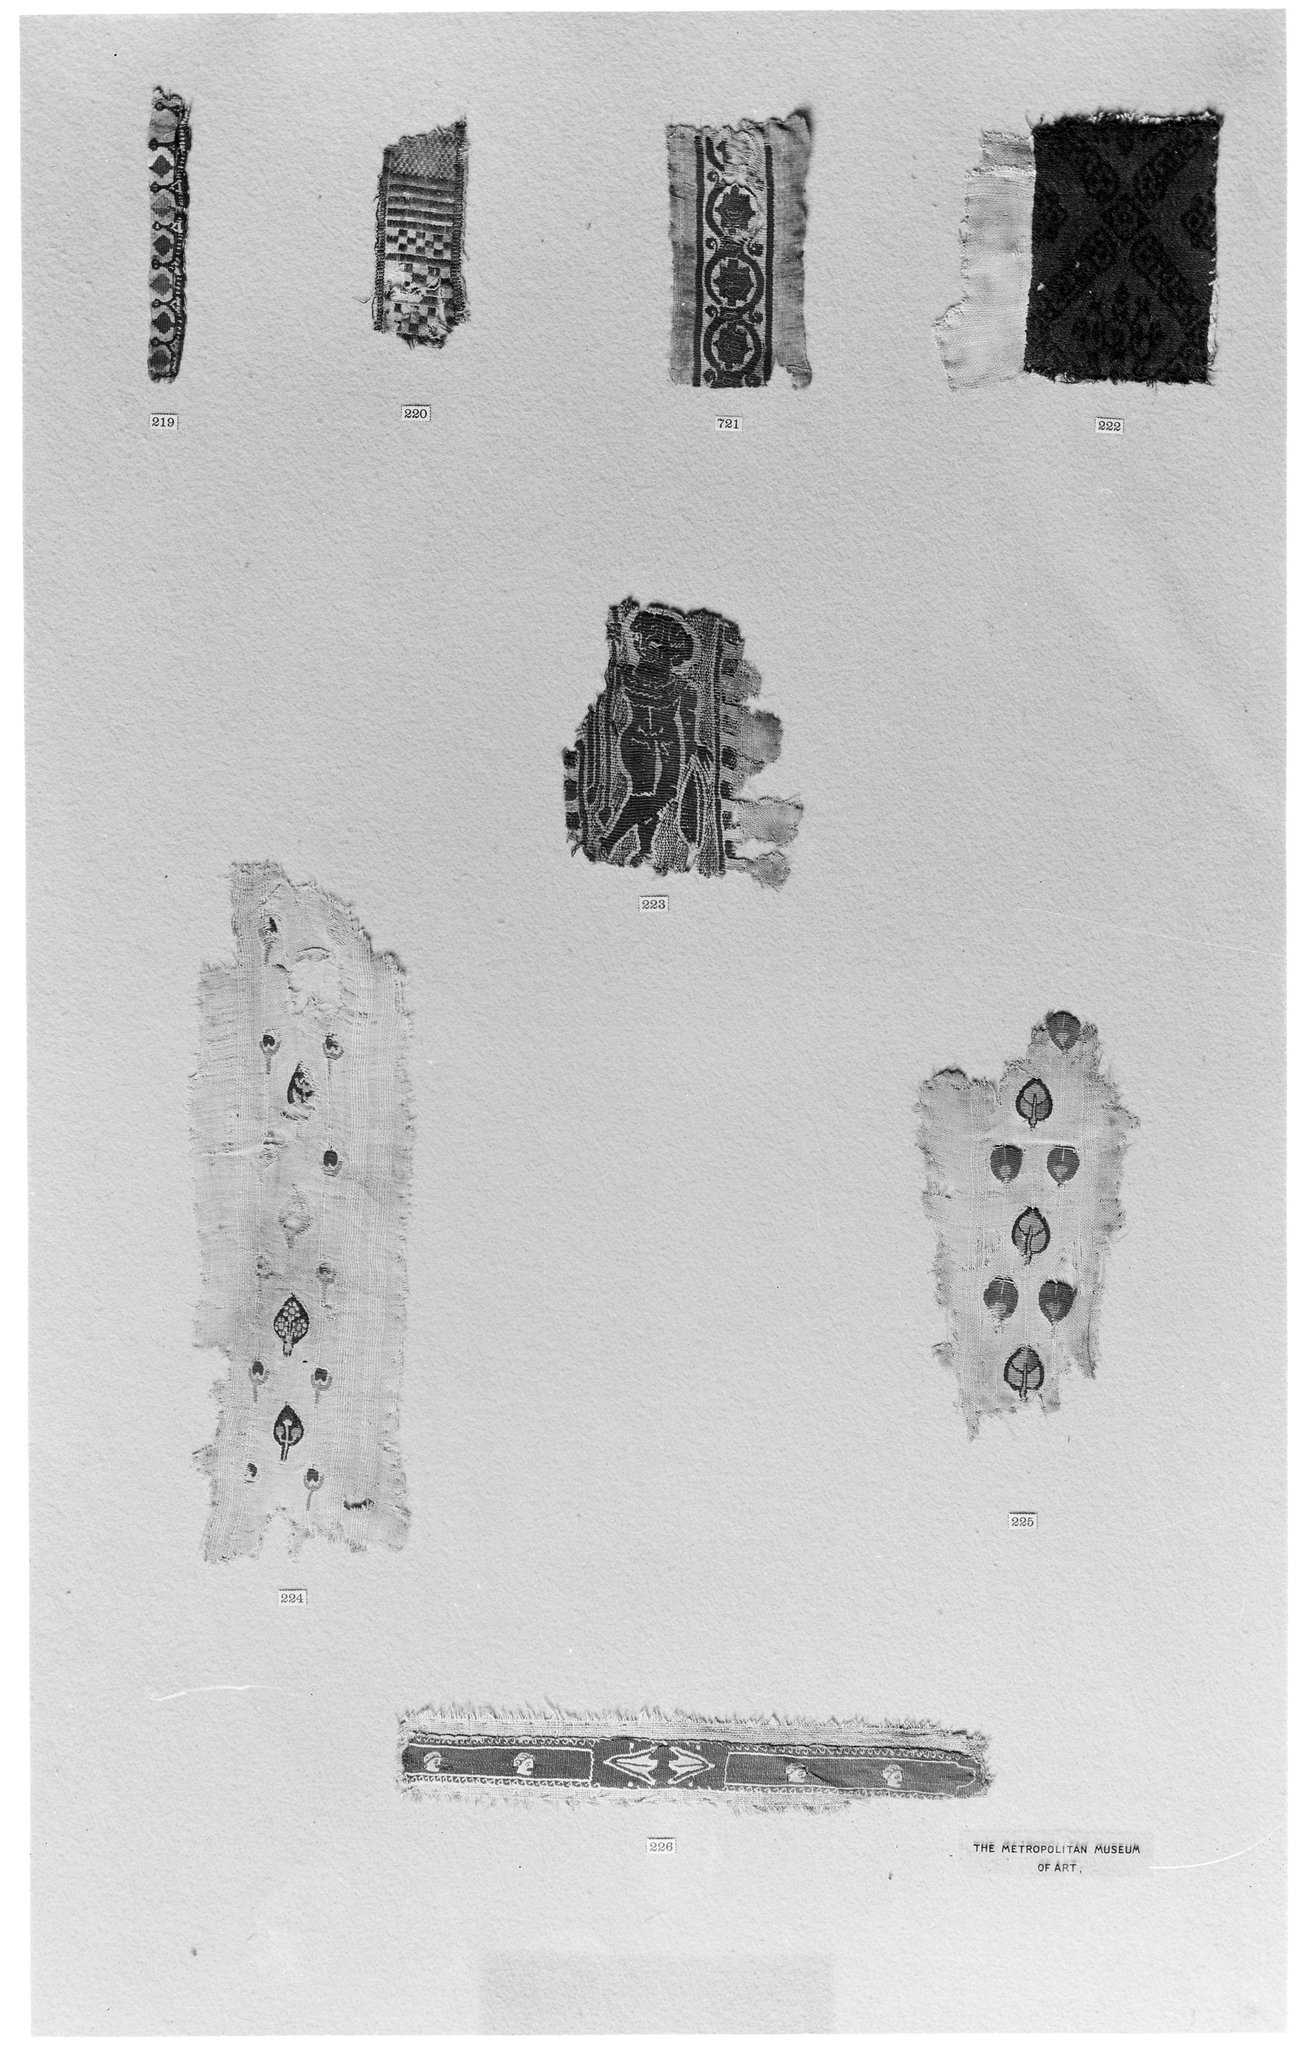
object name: textile fragment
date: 301-500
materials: linen, wool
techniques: weave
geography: egypt